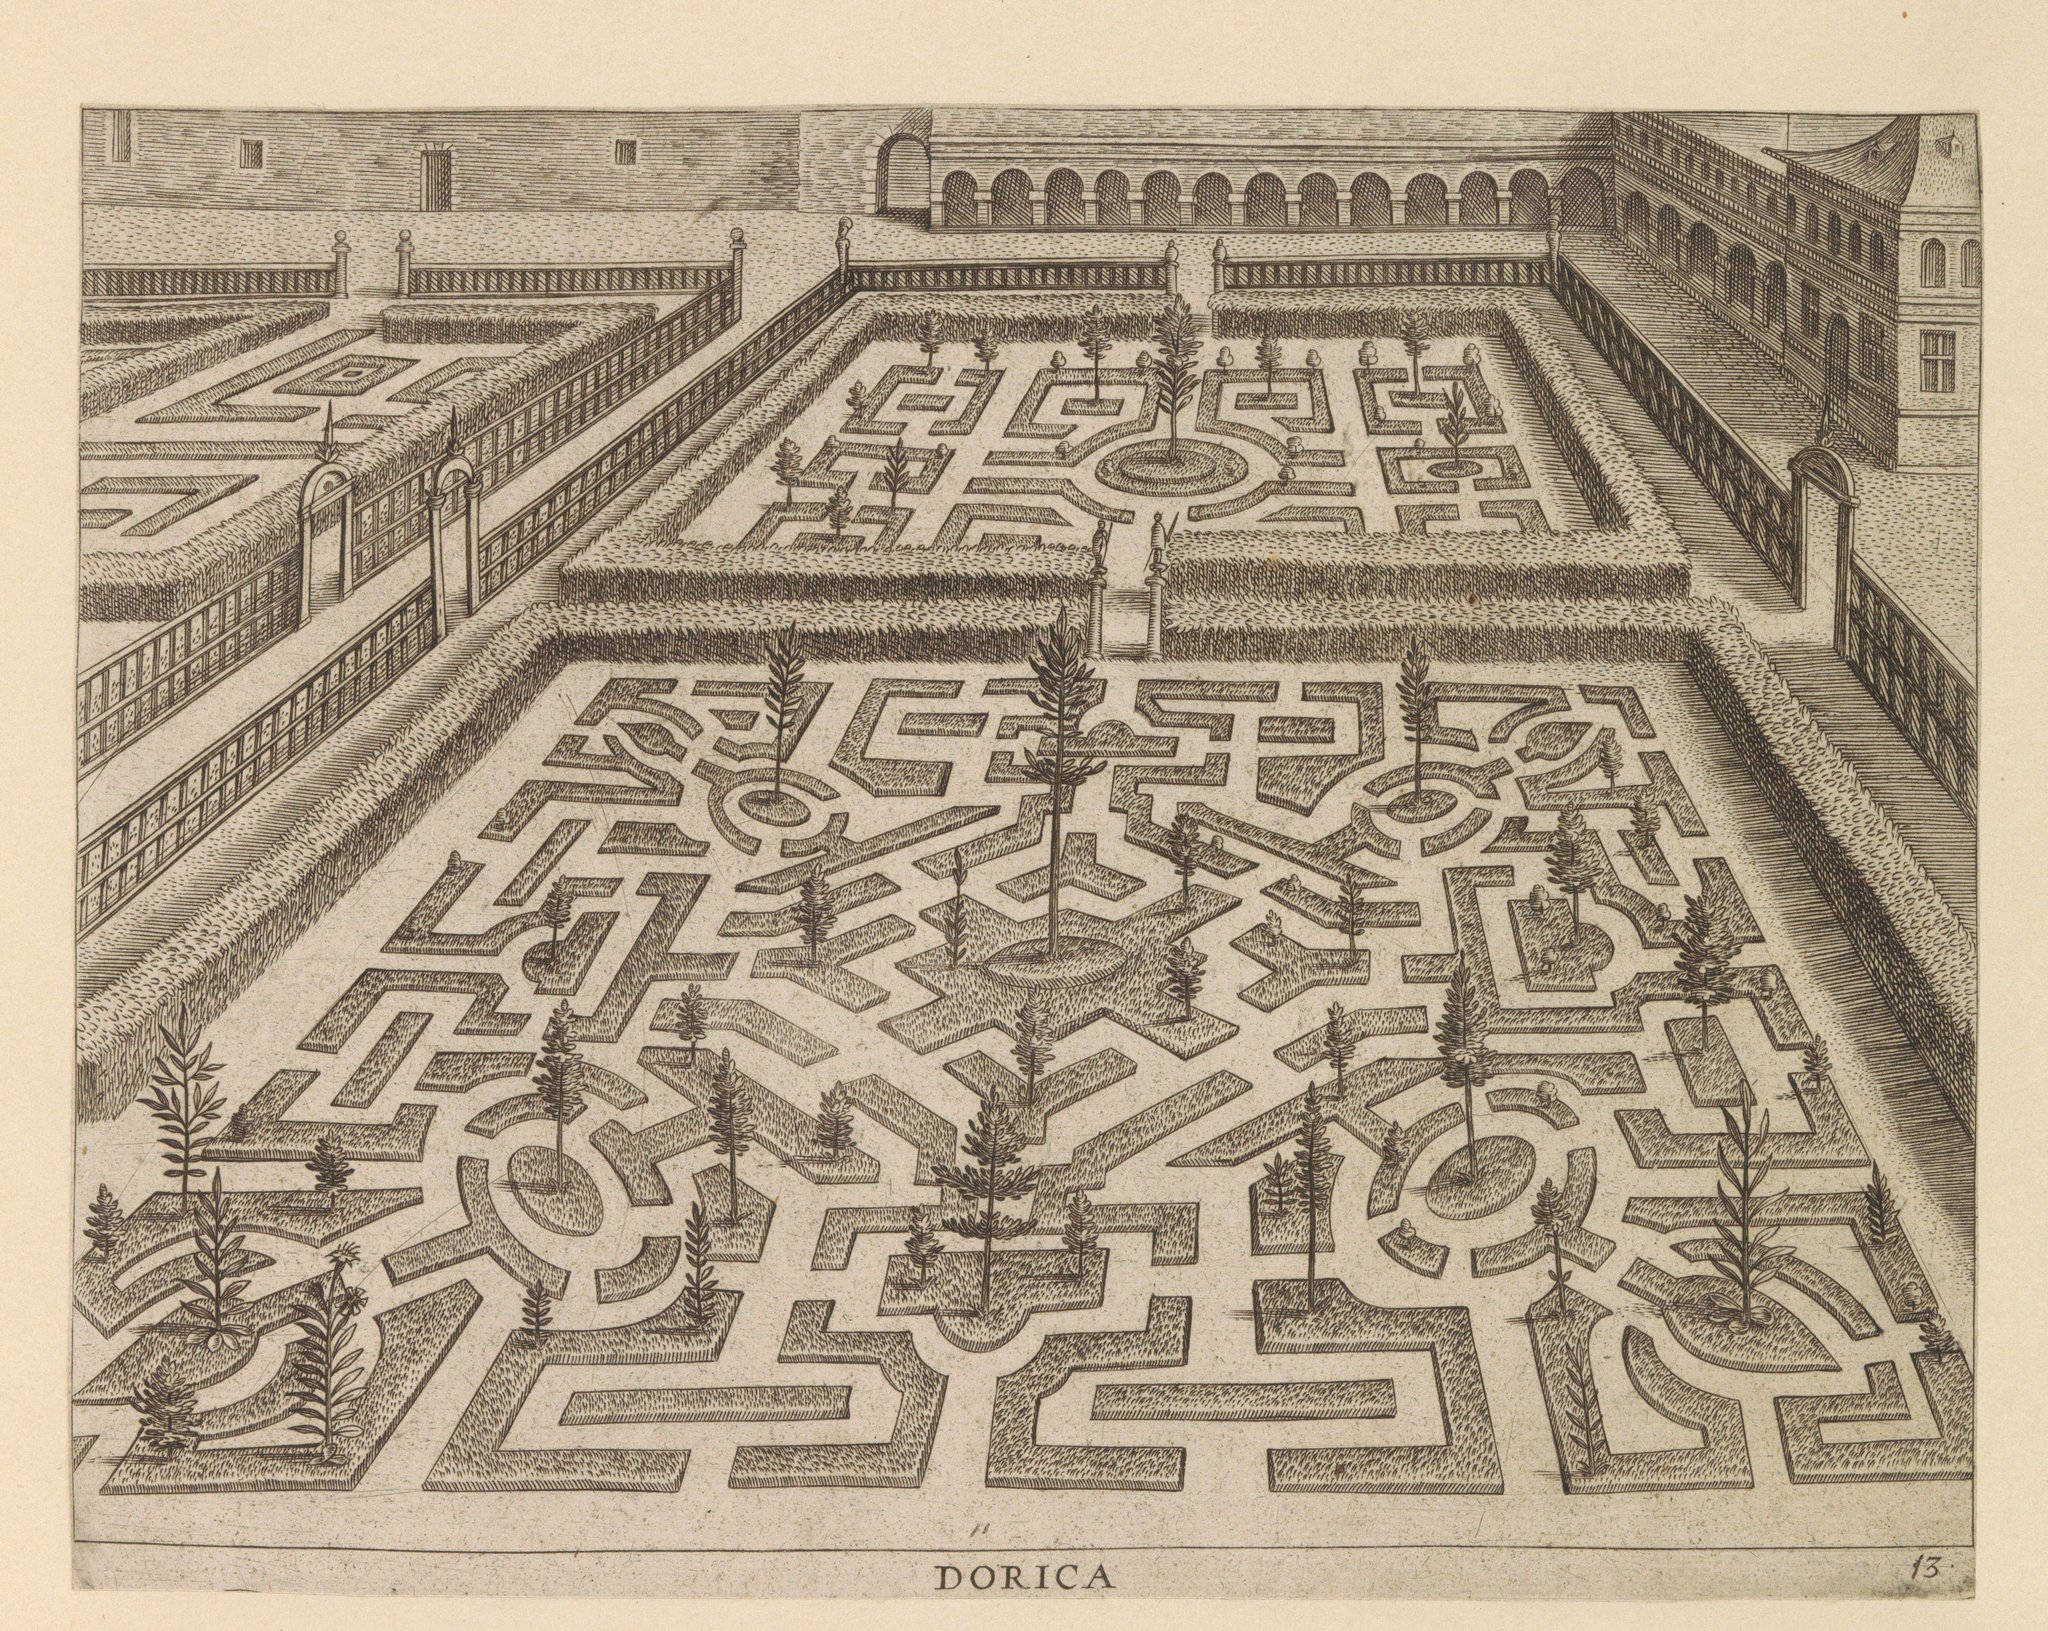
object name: ornament print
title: Tuinontwerpen geassocieerd met de Dorische, Ionische en Korinthische bouworden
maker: Anonymous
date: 1583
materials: paper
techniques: etching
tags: garden, french or architectonic garden; formal garden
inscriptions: inscription: ‘1’, inscription: ‘11’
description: Tuin met centrale parterre met bomen en heesters. De tuin is aangelegd volgens de Dorische bouworde. De prent maakt deel uit van een album.